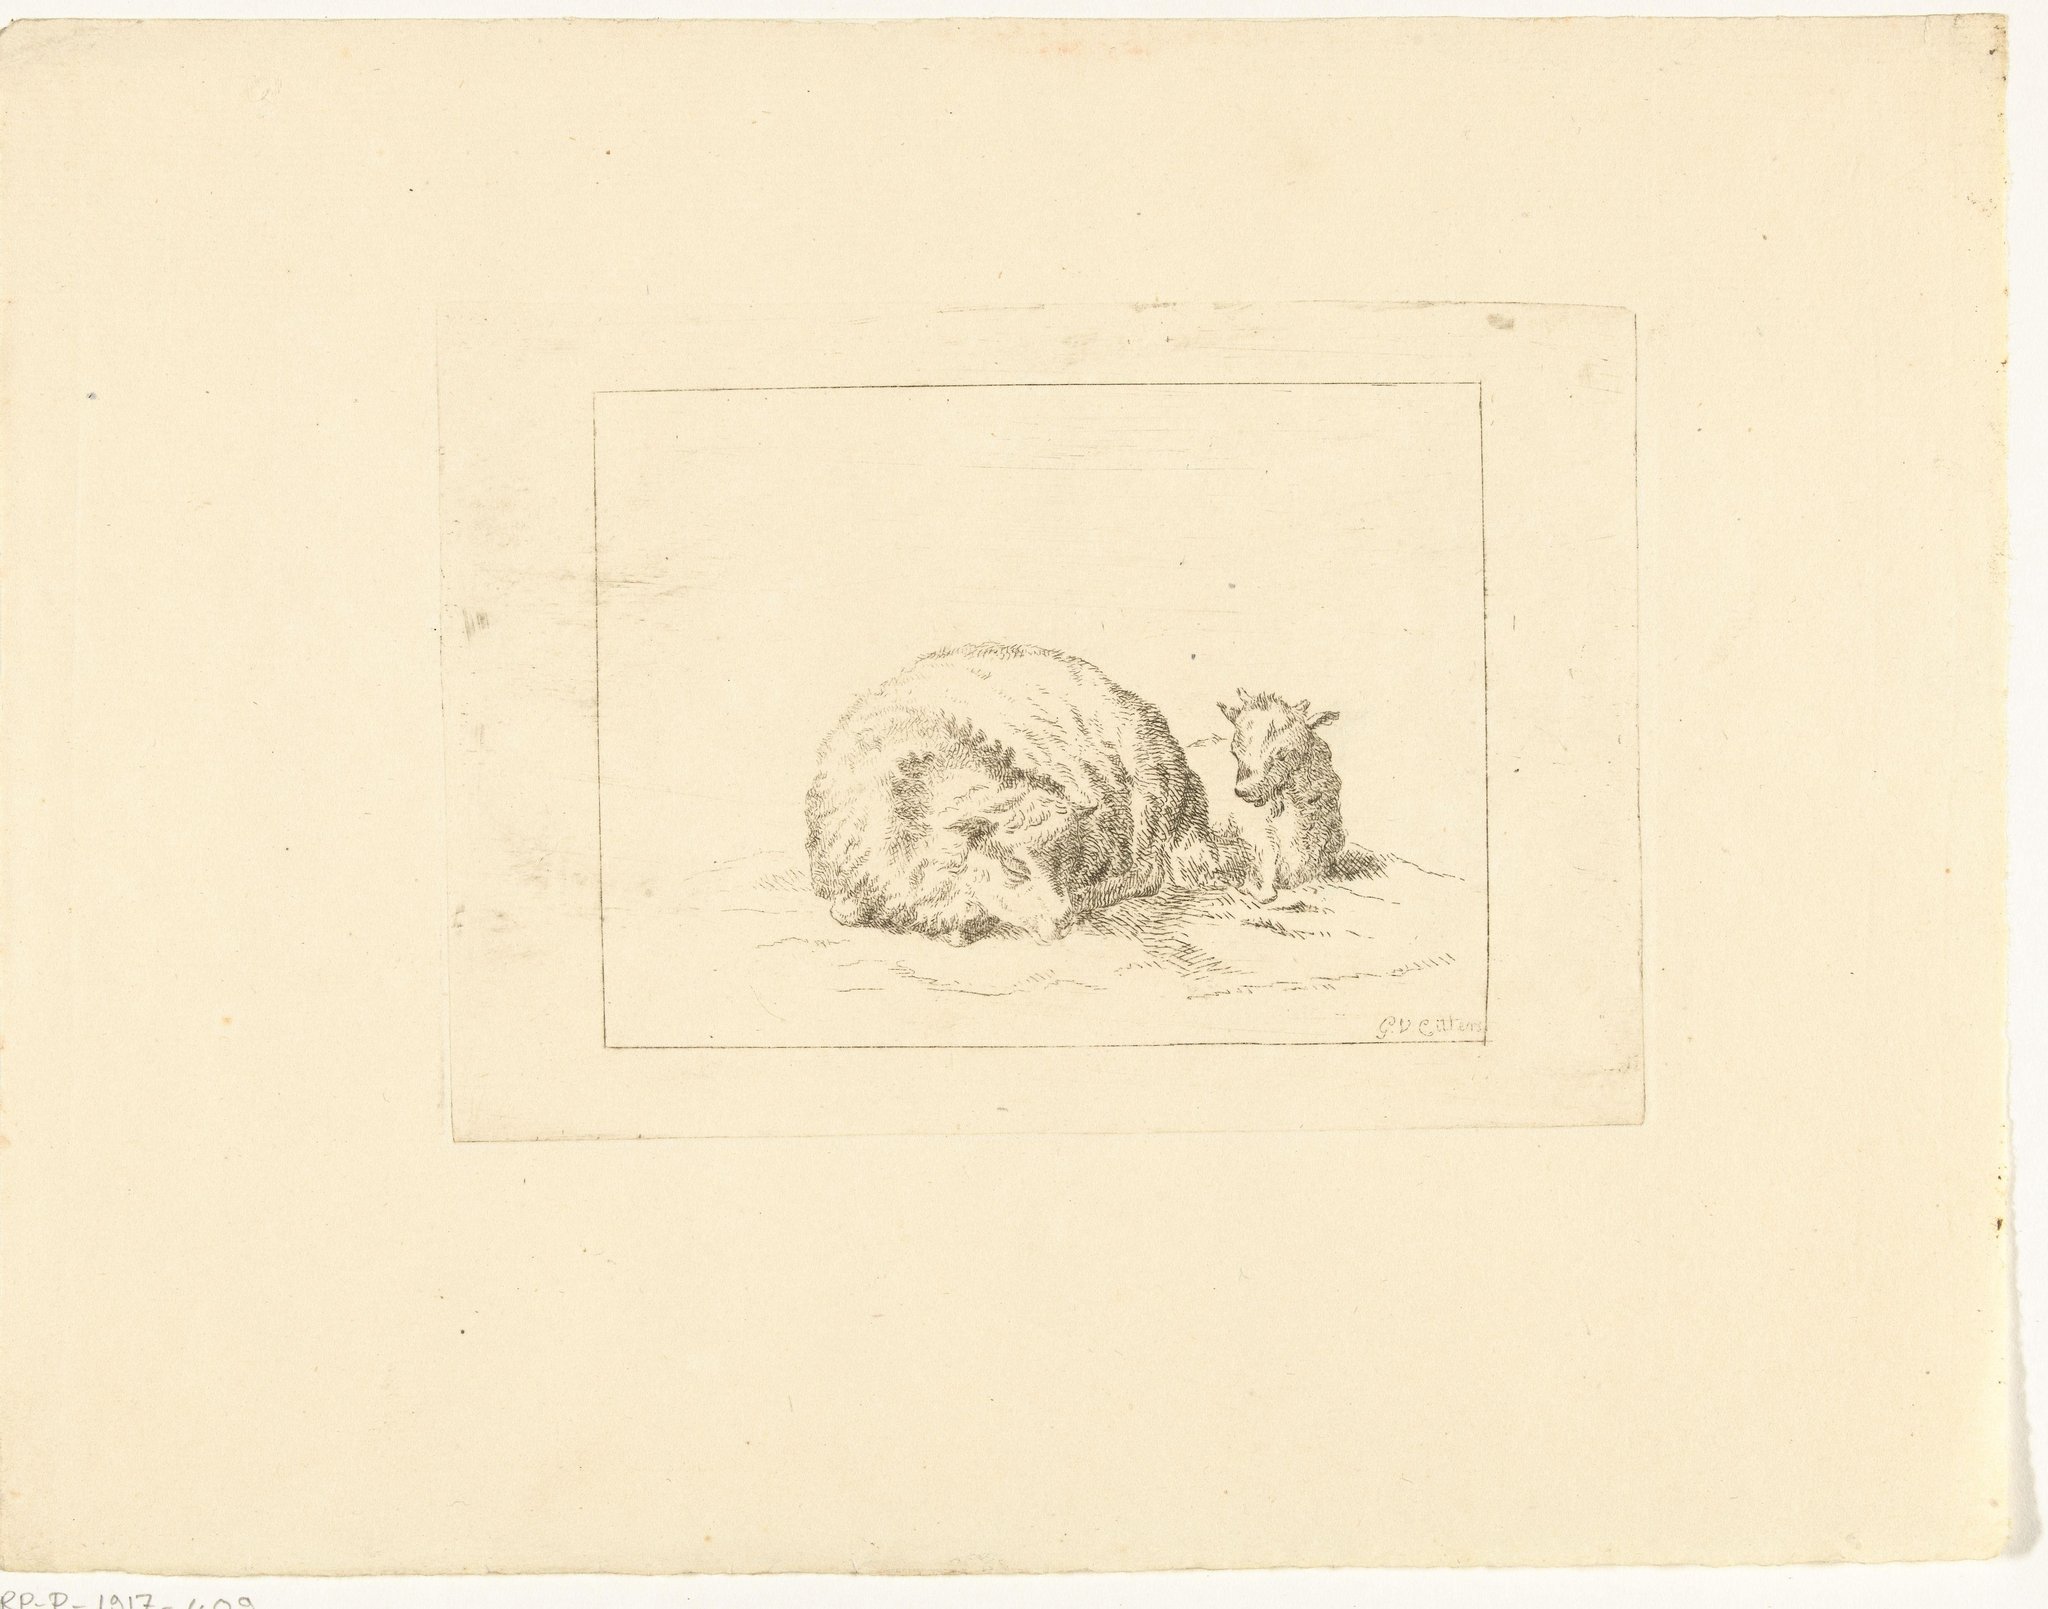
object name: print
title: Slapende schapen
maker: g. van citters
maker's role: print maker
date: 1750-1800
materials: paper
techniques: etching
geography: netherlands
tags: sheep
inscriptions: collector's mark: Lugt 2233